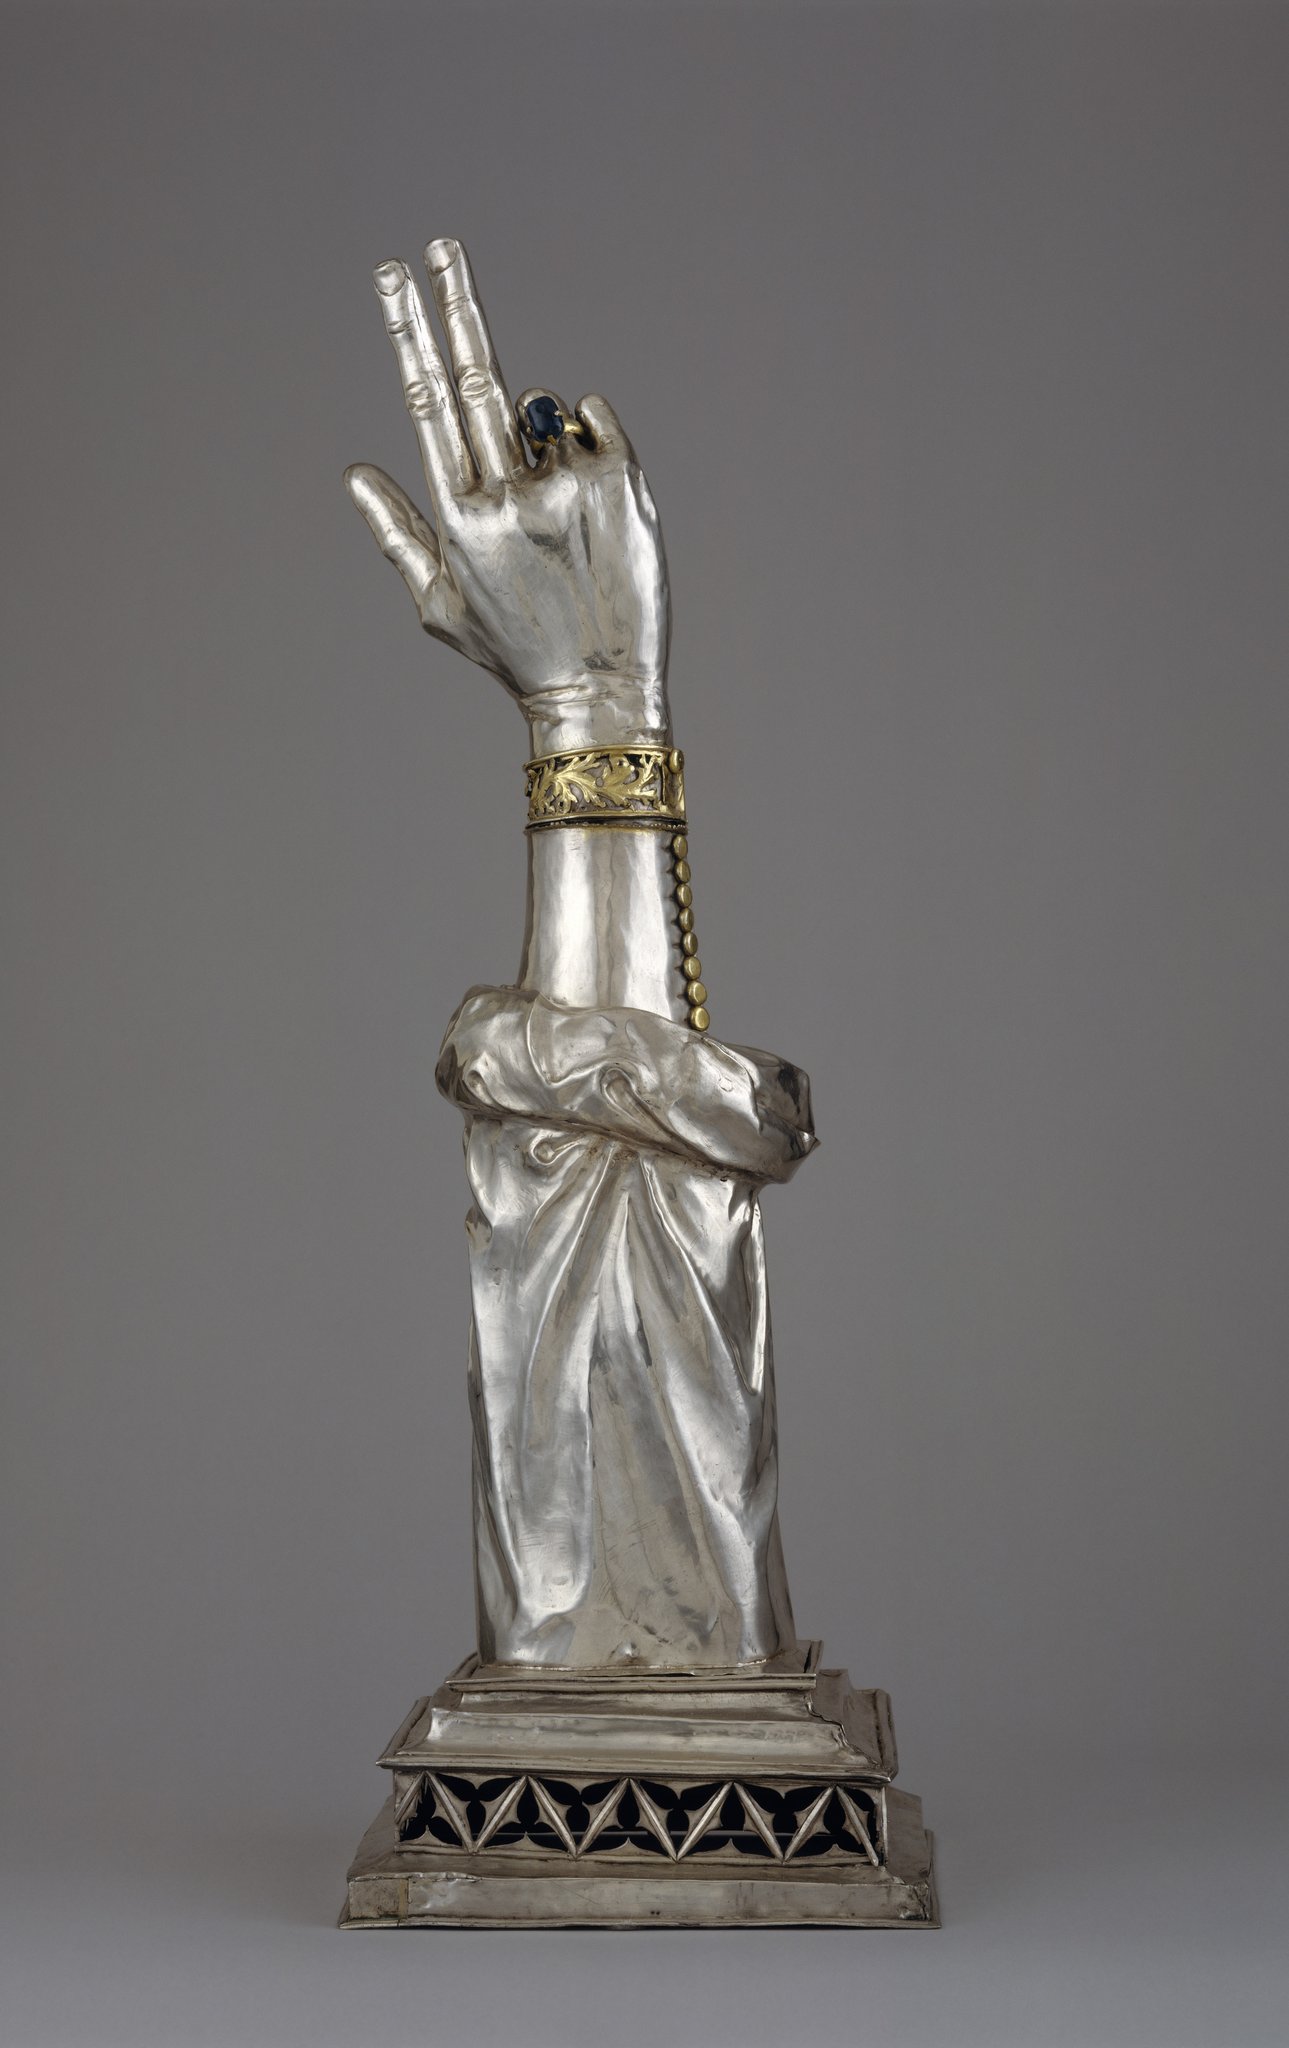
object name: reliquary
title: Reliquary Arm of St. Valentine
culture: swiss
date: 1301-1400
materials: gilt, gemstone, silver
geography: switzerland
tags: hands